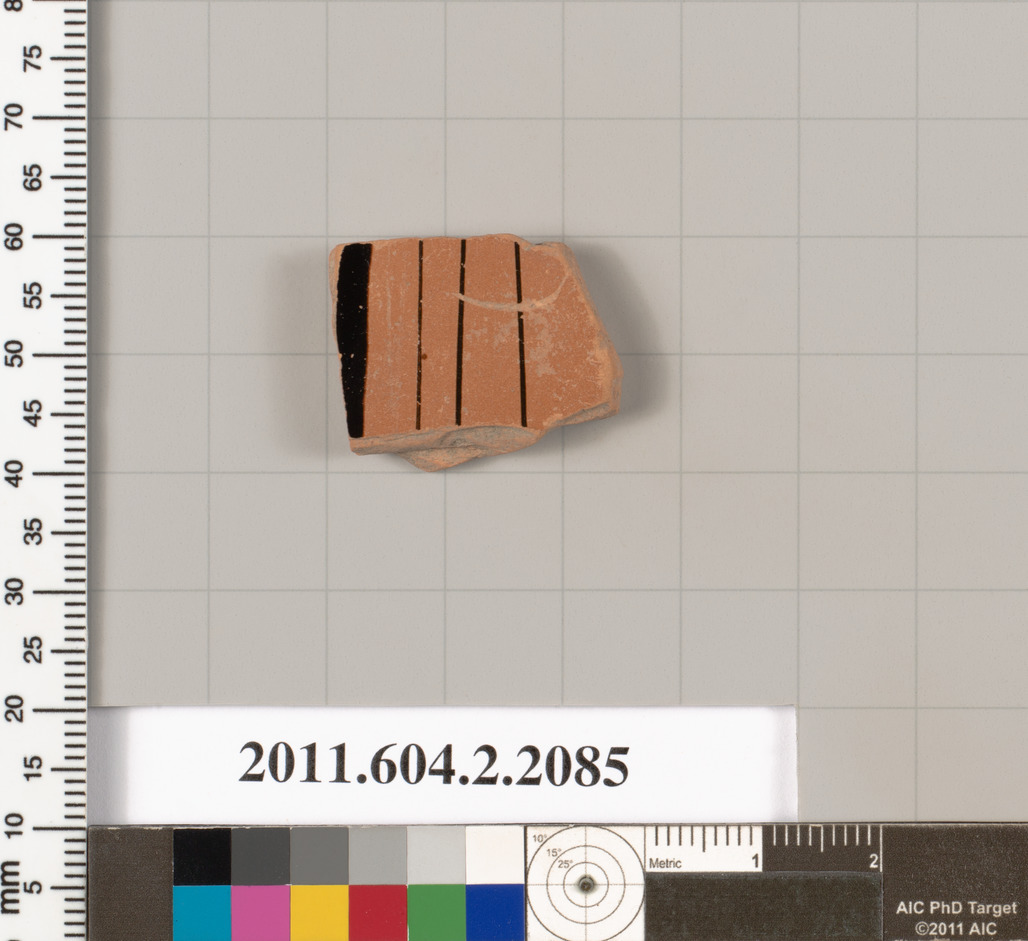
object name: pot fragment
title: Terracotta fragment of a pot; glazed on the inside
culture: greek, attic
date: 475-451 BCE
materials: terracotta